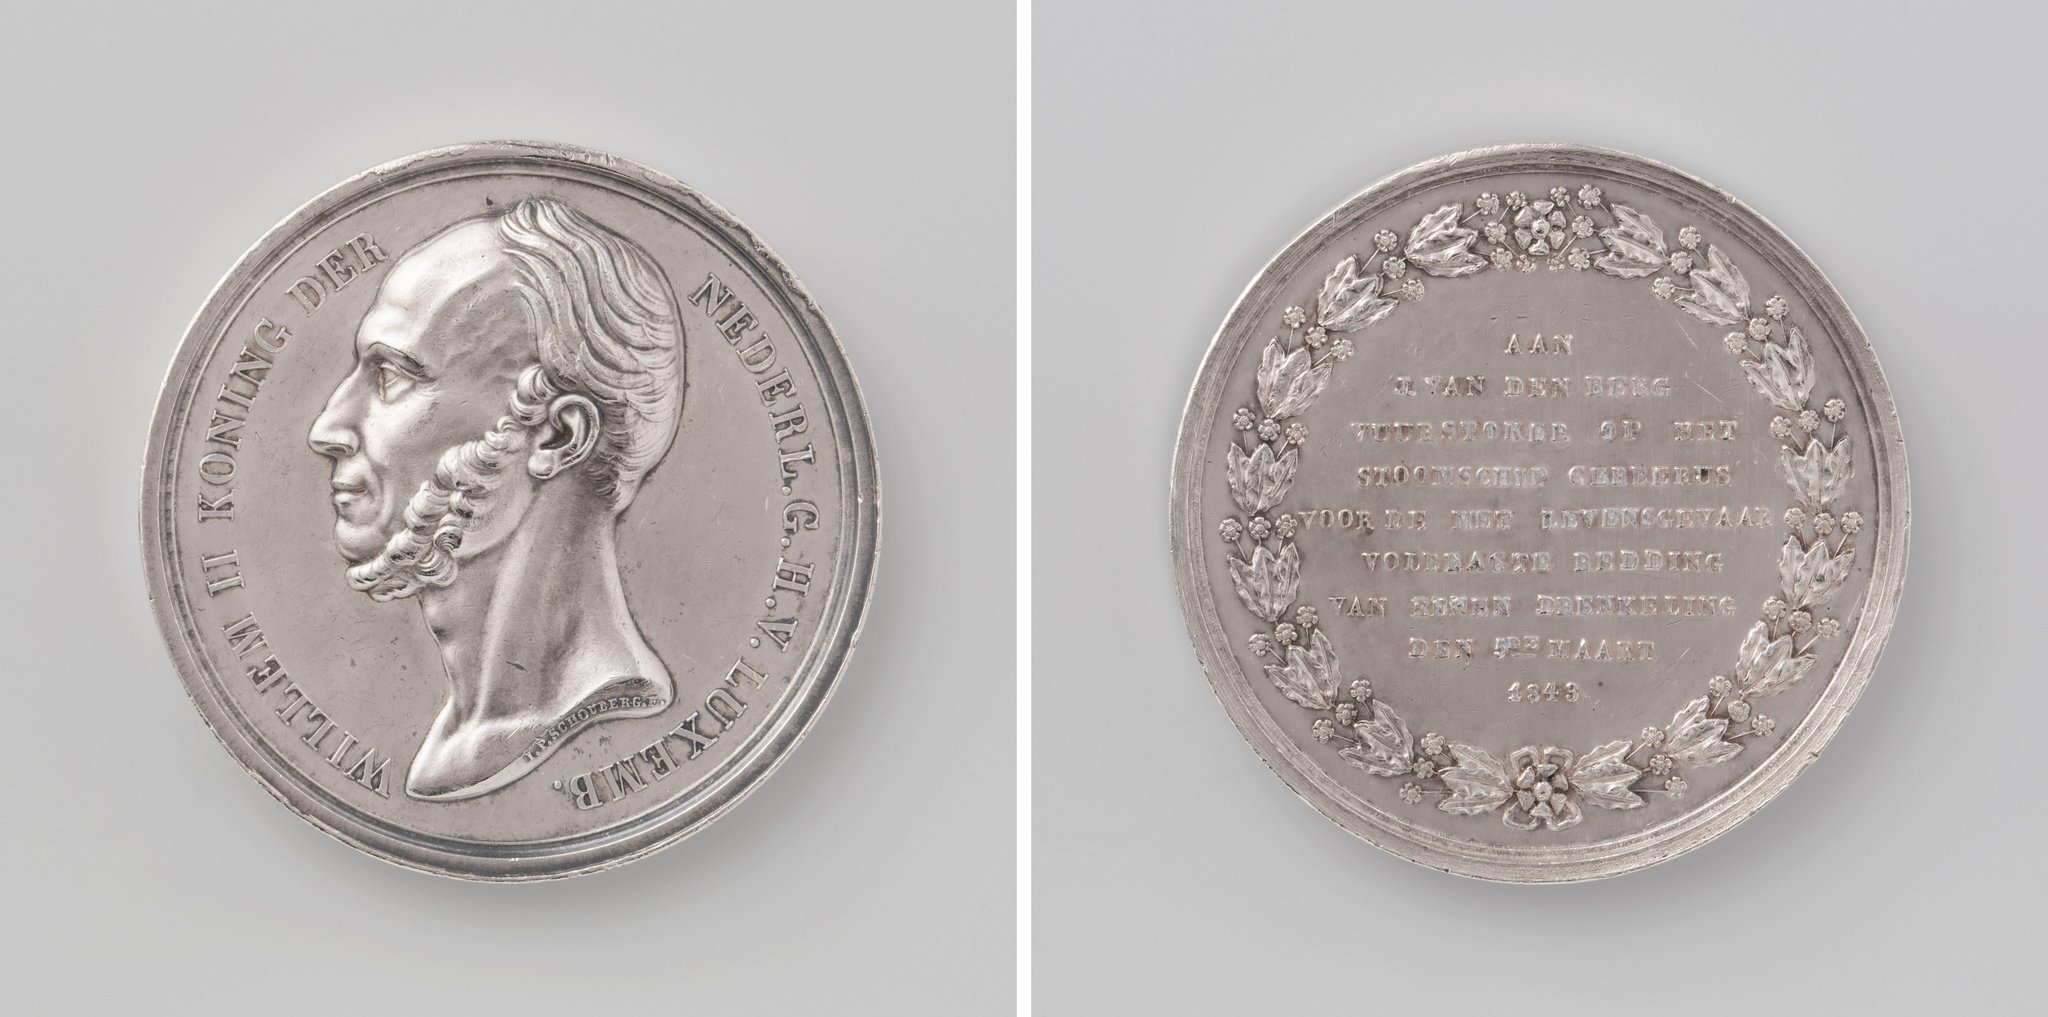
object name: honorary medal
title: J. van den Berg, stoker op het schip Cerberus, penning ontvangen wegens het redden van een drenkeling, vereerd in opdracht van Willem II, koning der Nederlanden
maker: johannis petrus schouberg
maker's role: die cutter, draughtsman, print maker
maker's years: 1798-1864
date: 1843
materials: silver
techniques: striking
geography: utrecht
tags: the hague, william ii of the netherlands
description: Zilveren penning. Voorzijde: borststuk man binnen omschrift. Keerzijde: opschrift binnen krans van myrte-loof